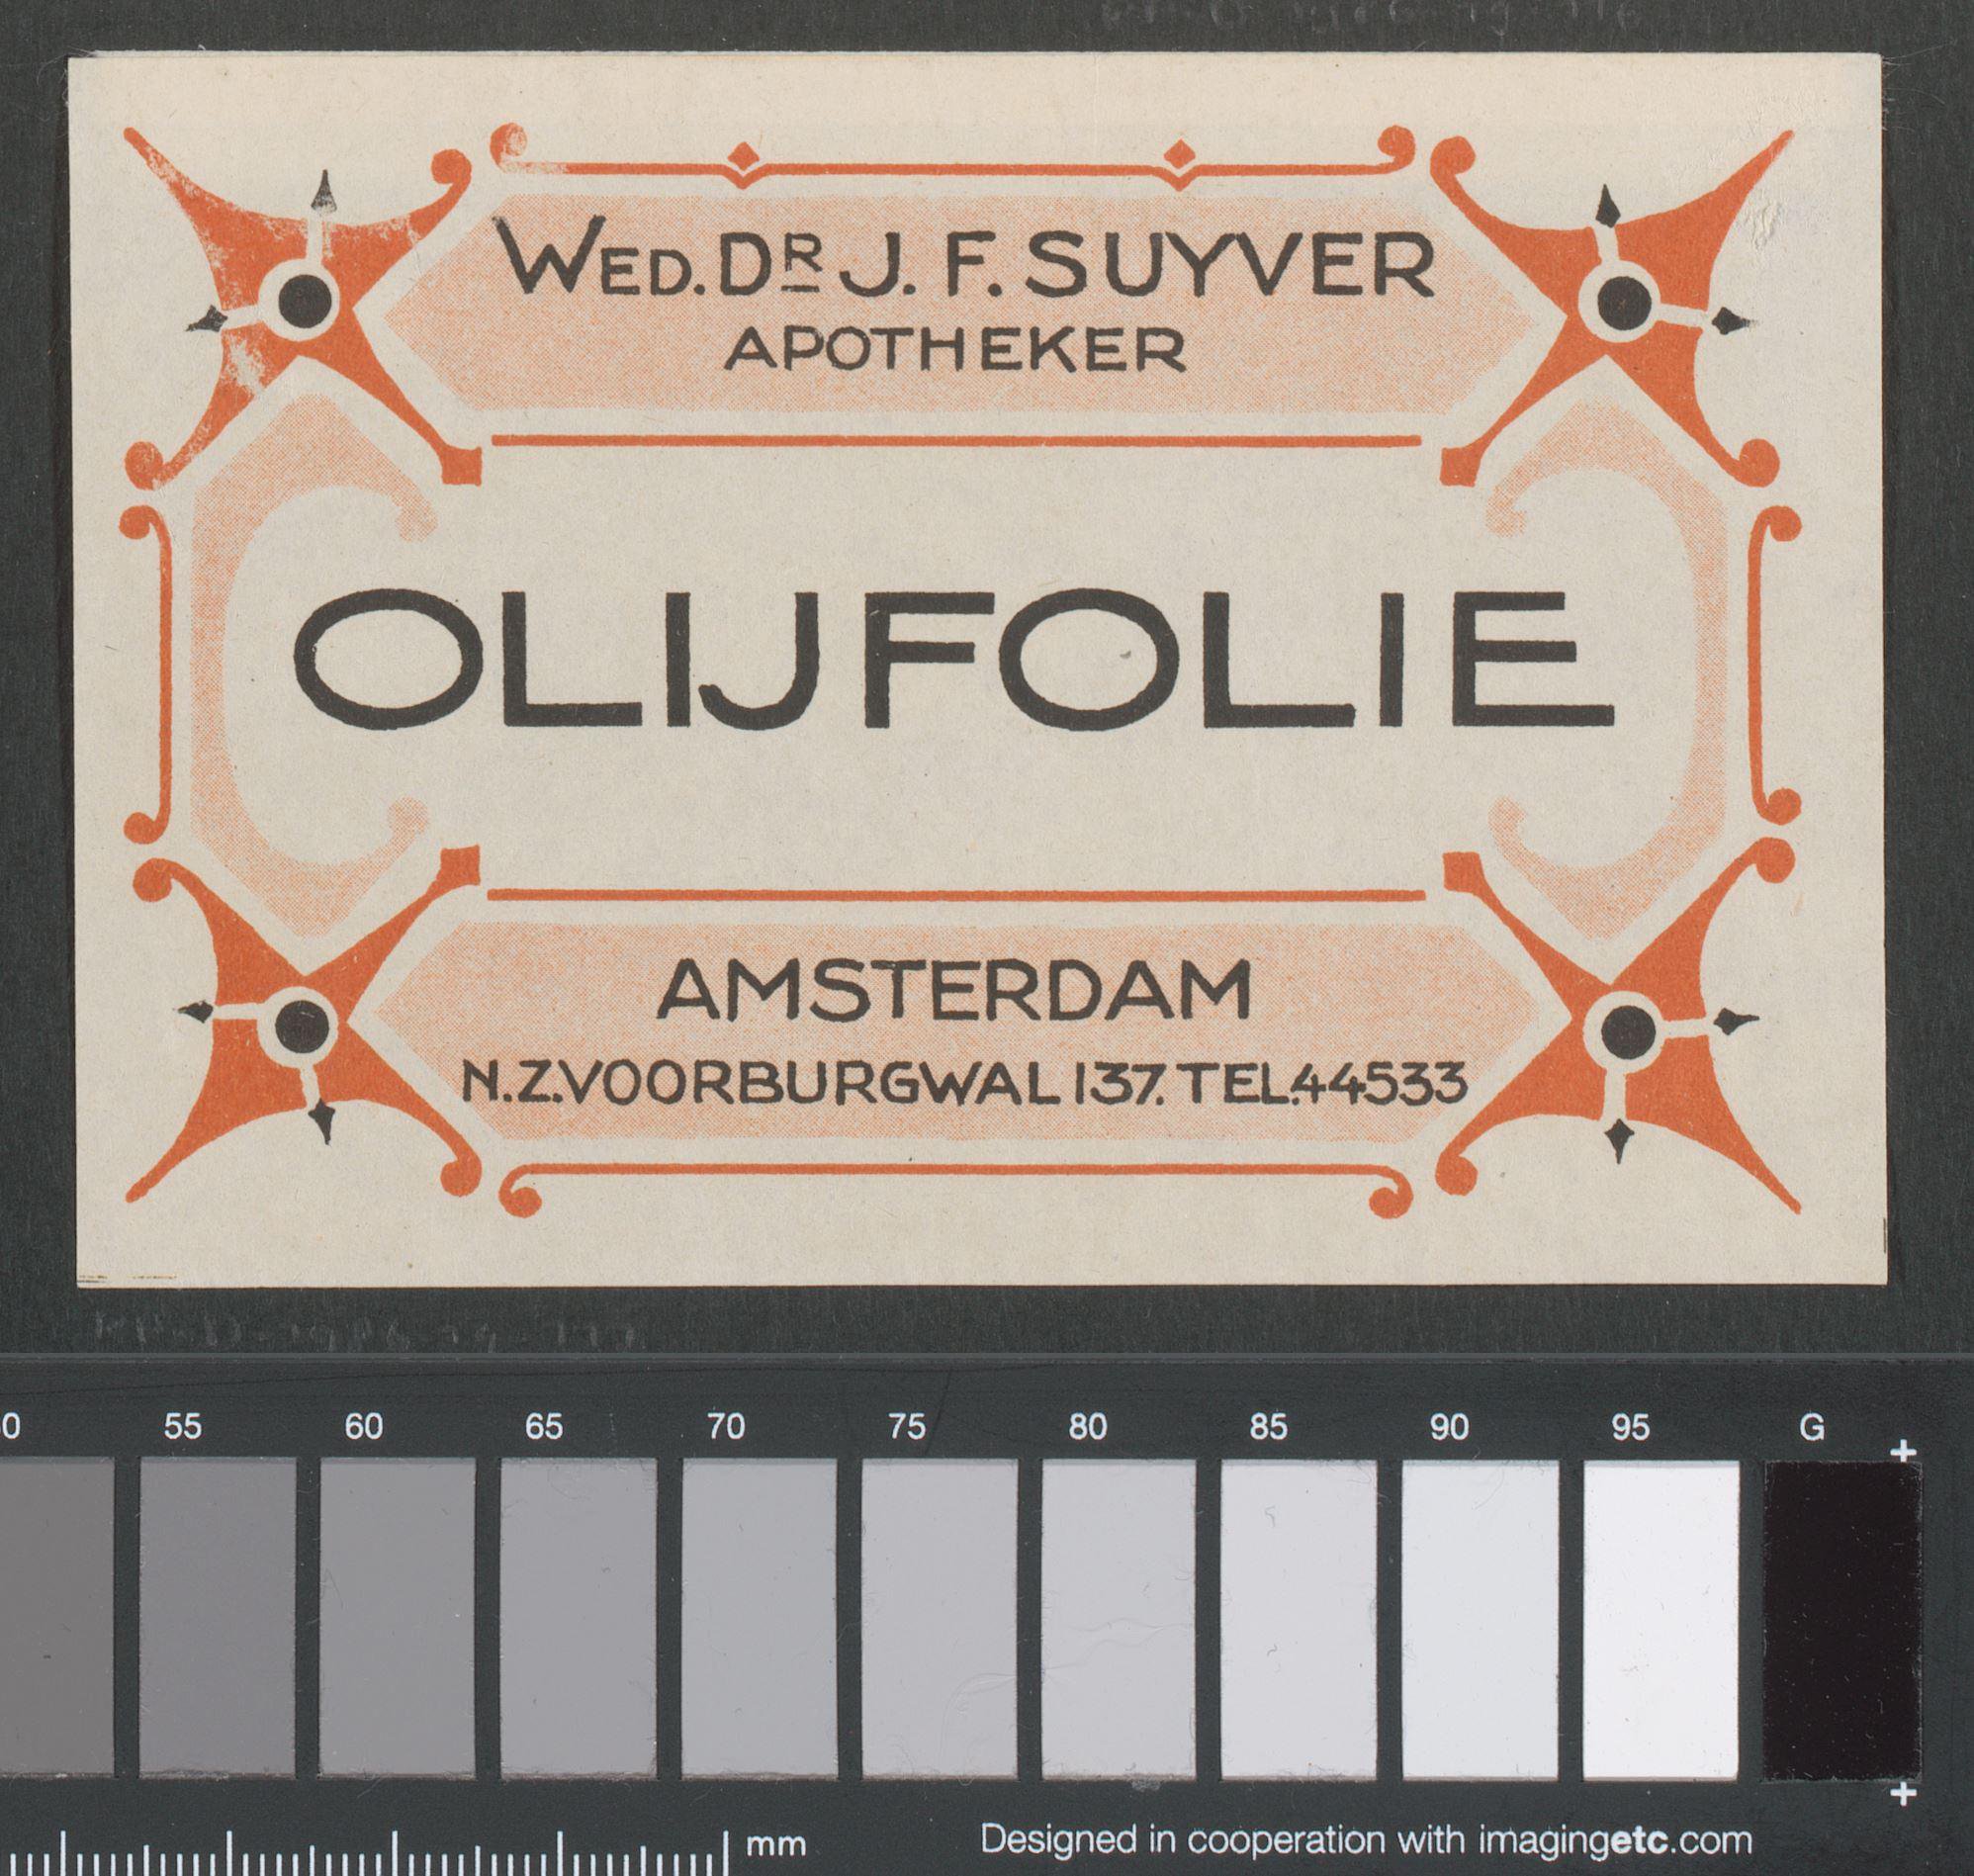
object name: print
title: Apothekersetiket voor olijfolie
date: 1931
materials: paper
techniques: lithograph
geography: hilversum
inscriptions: collector's mark: ‘R:MVS.’